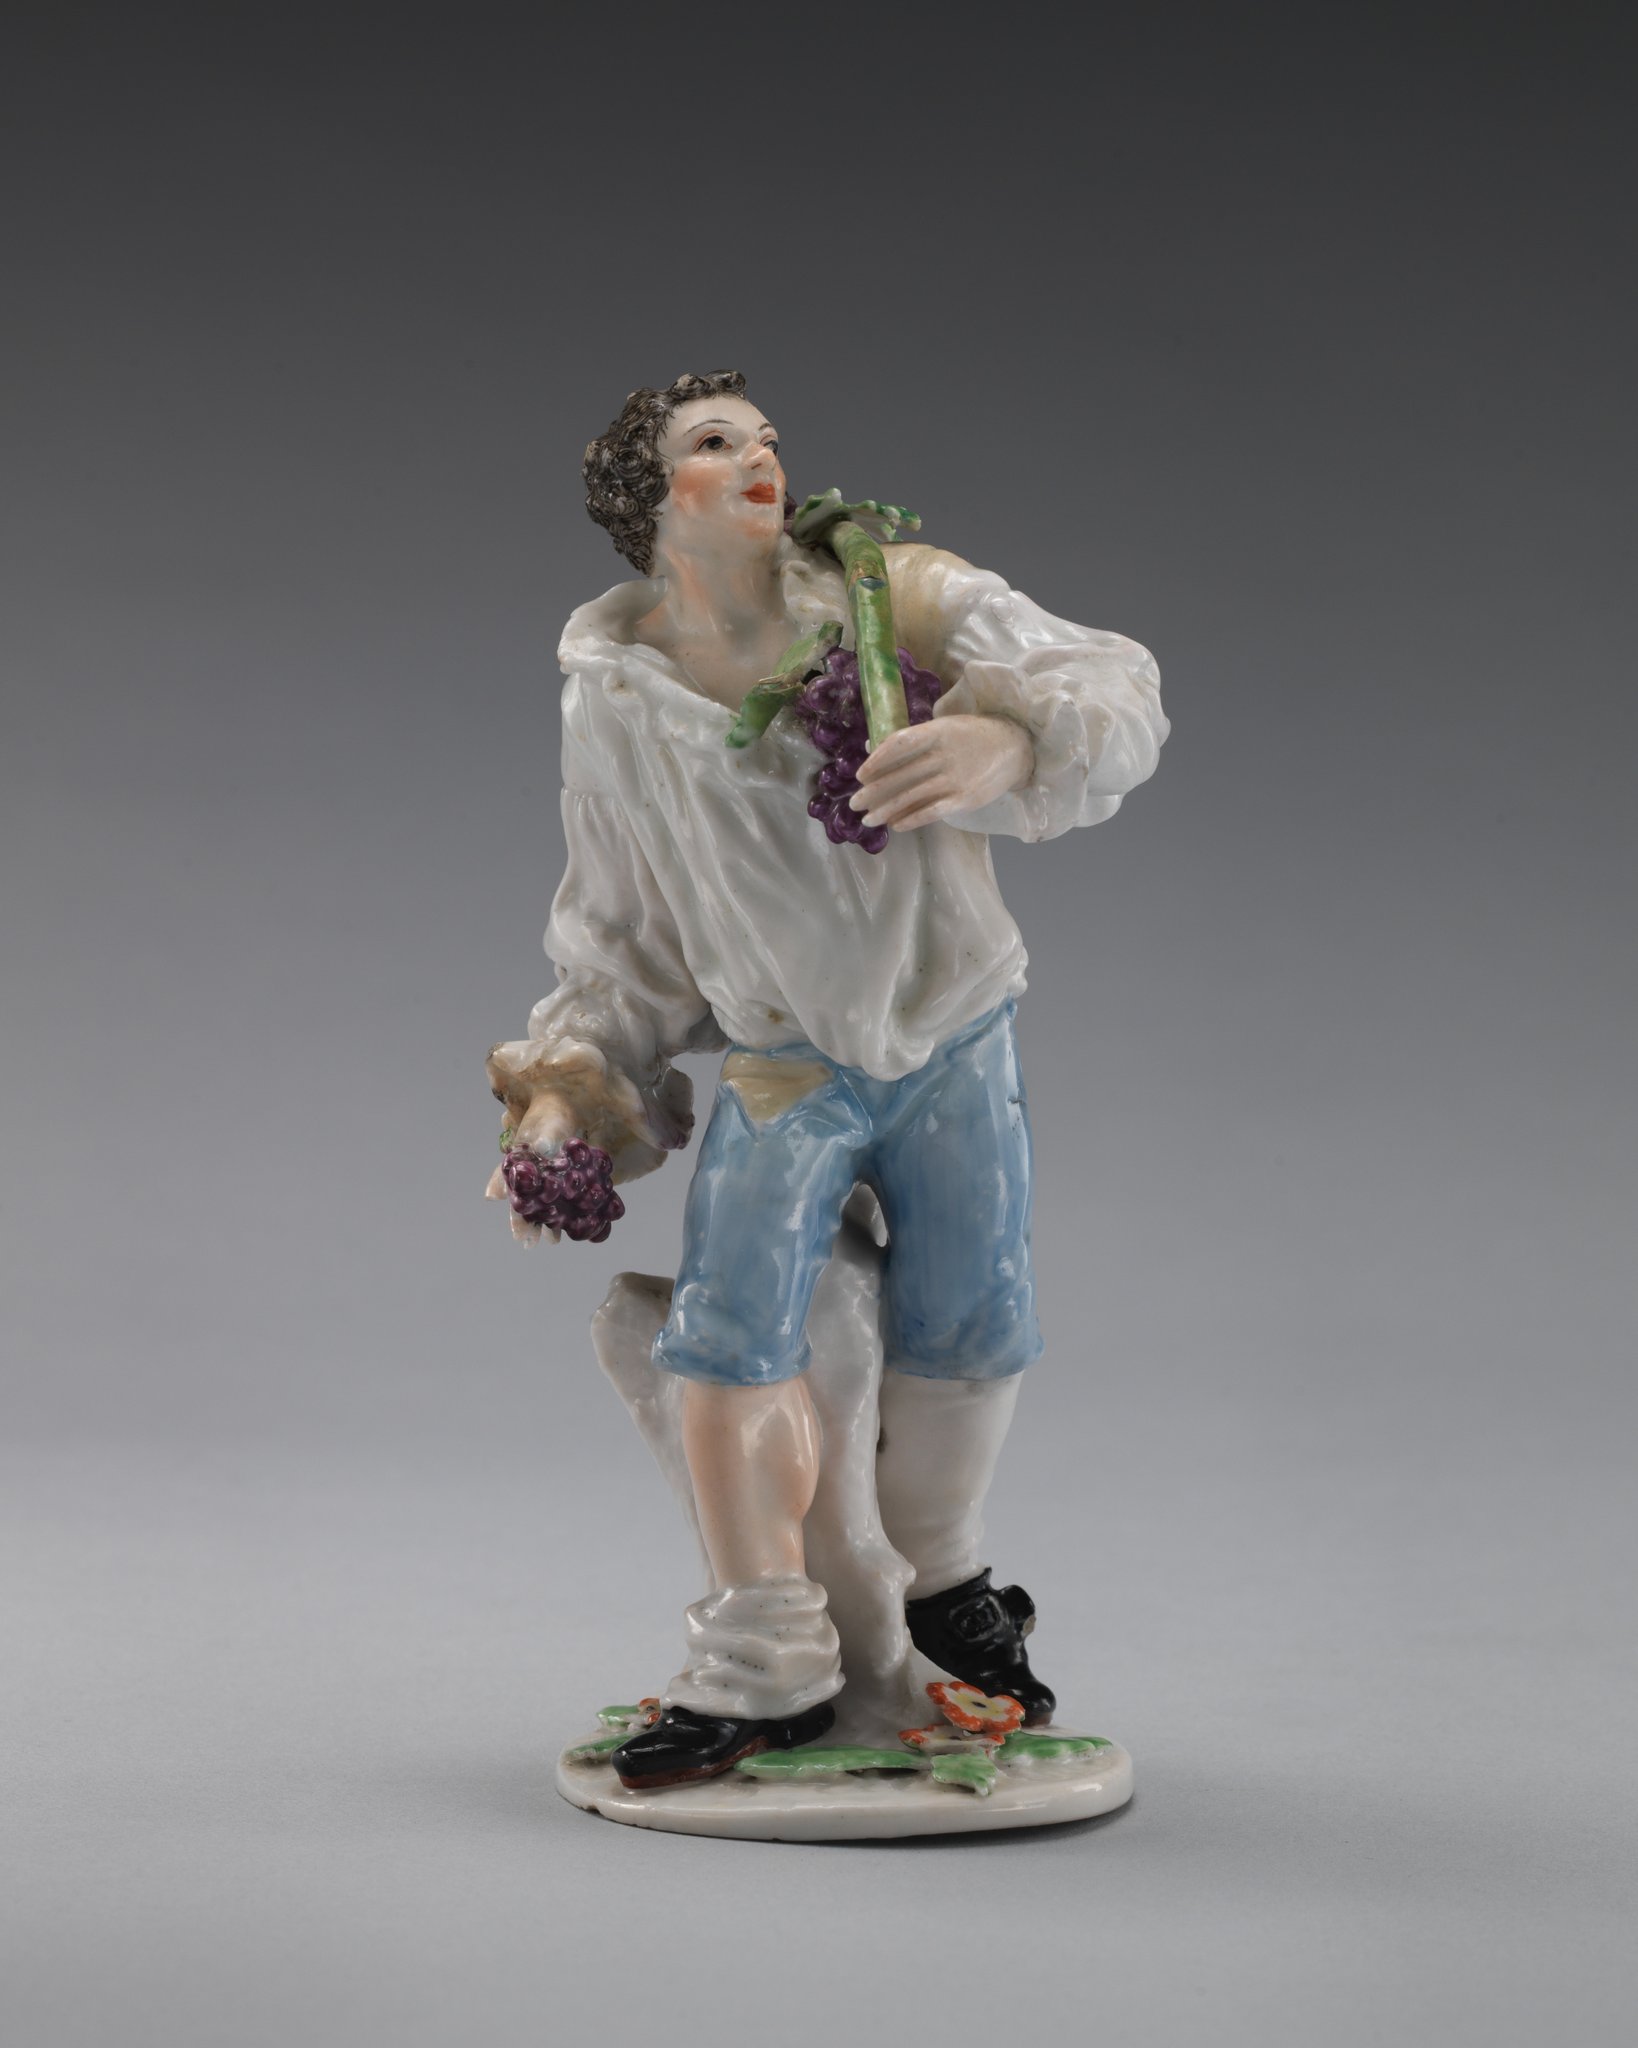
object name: figure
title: Four Seasons (Autumn)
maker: chelsea porcelain manufactory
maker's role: factory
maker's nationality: british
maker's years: 1744-1784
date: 1753-1755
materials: soft paste porcelain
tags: grapes,men,autumn